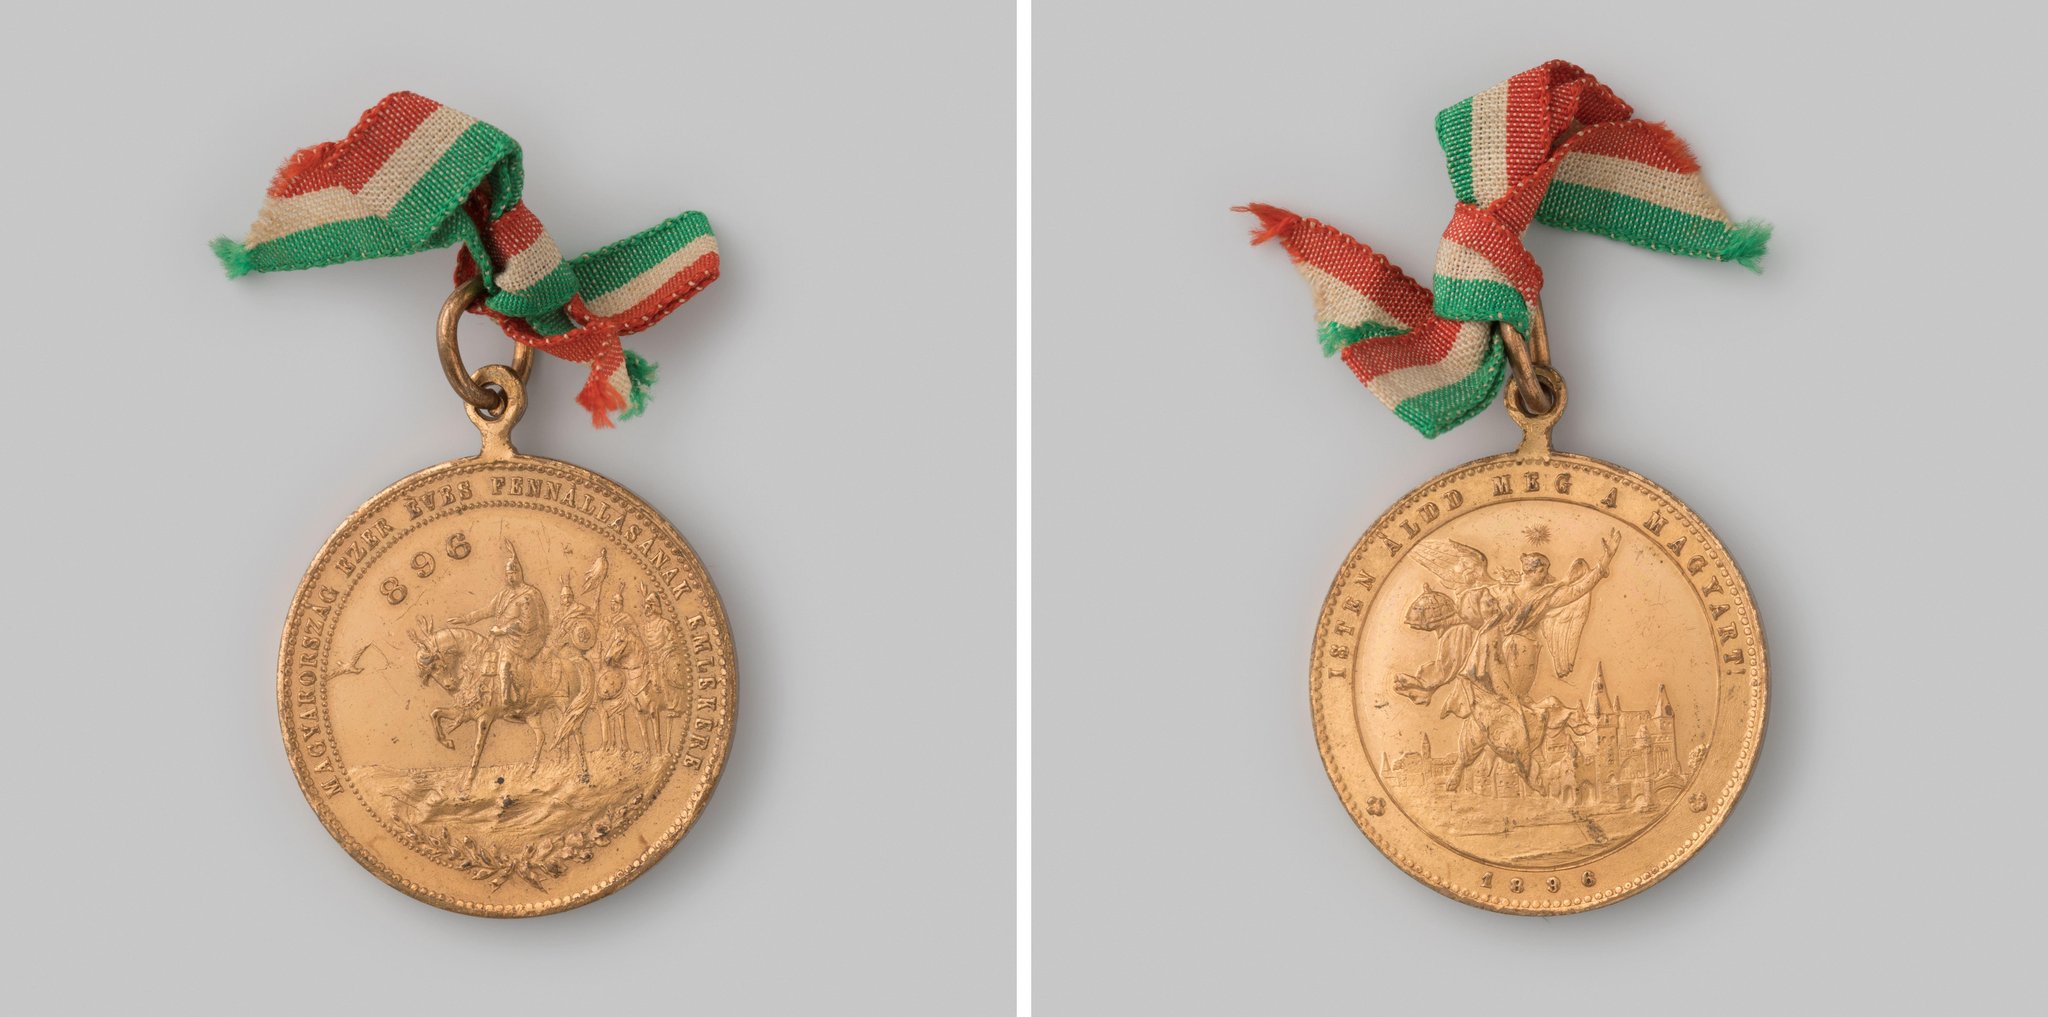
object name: history medal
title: Duizendjarige herdenking van de inval van Magyaren in Hongarije 1896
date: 1896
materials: brass, textile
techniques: striking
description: Vergulde penning met oog en draagring aan een rood-wit-groene strik, op de voorzijde vier Magyaarse ruiters, het jaartal 896 in het veld, met omschrift, op de keerzijde een gevleugelde vrouw met kroon bij een vesting, met omschrift.